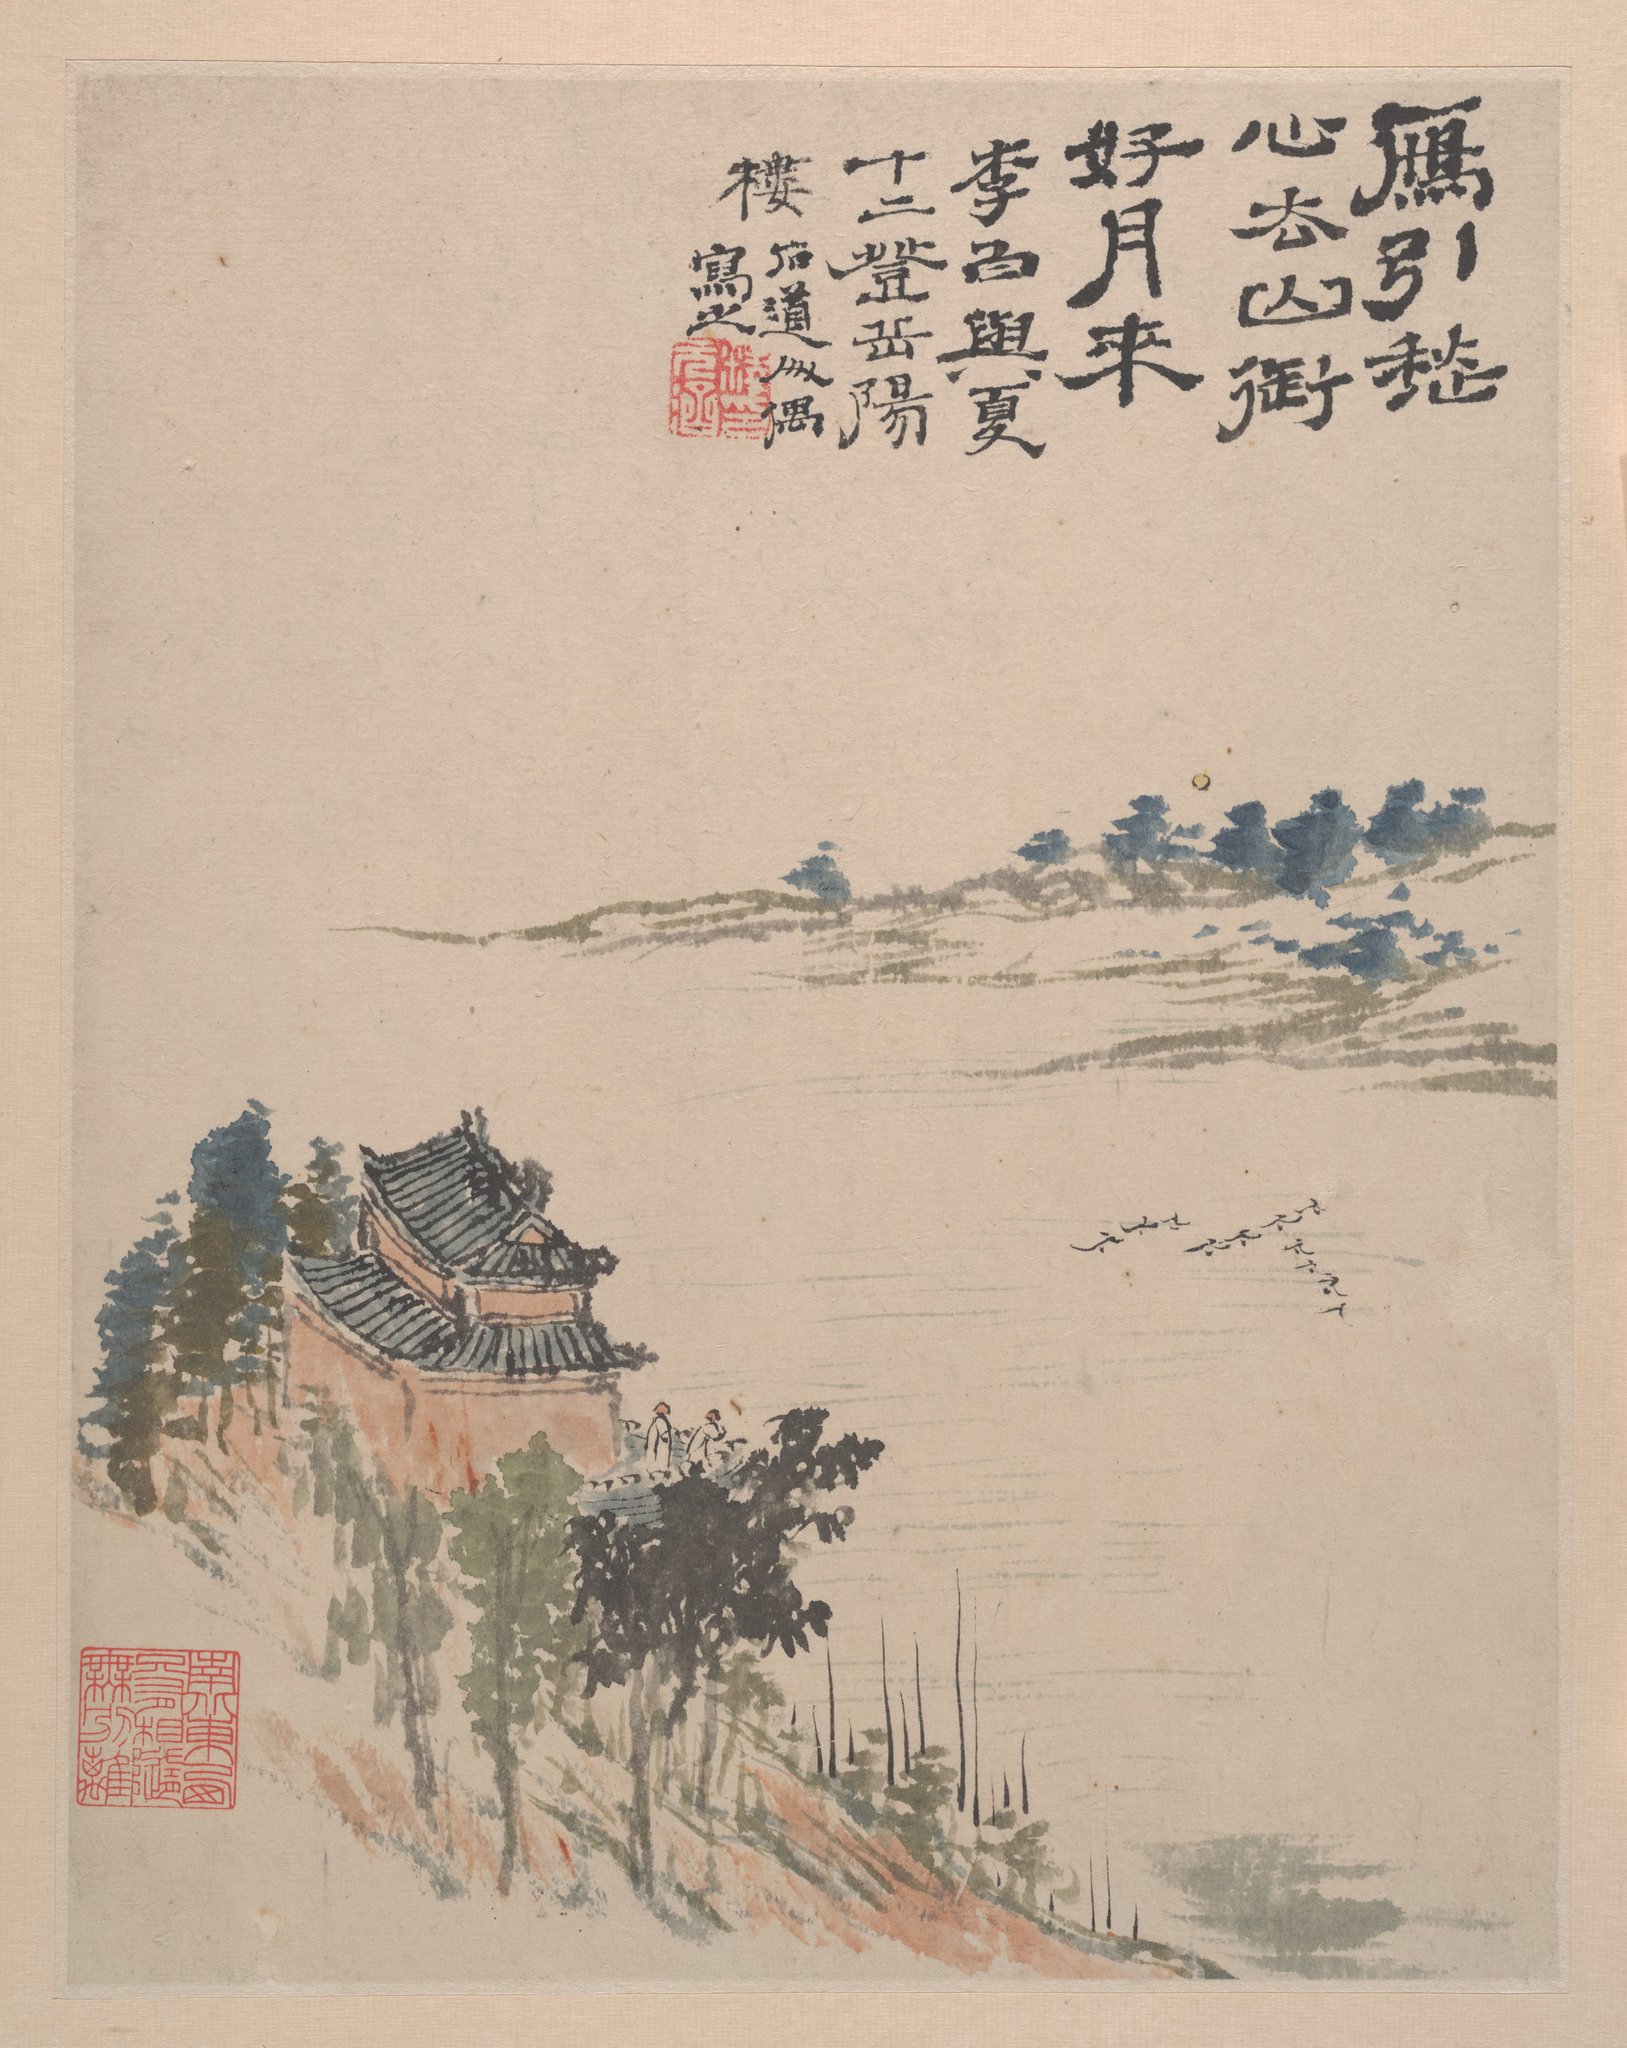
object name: album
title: Wilderness Colors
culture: chinese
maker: shitao (zhu ruoji)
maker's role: artist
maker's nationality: chinese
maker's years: 1642-1707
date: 1700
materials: ink, paper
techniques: painting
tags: vegetables,flowers,landscapes